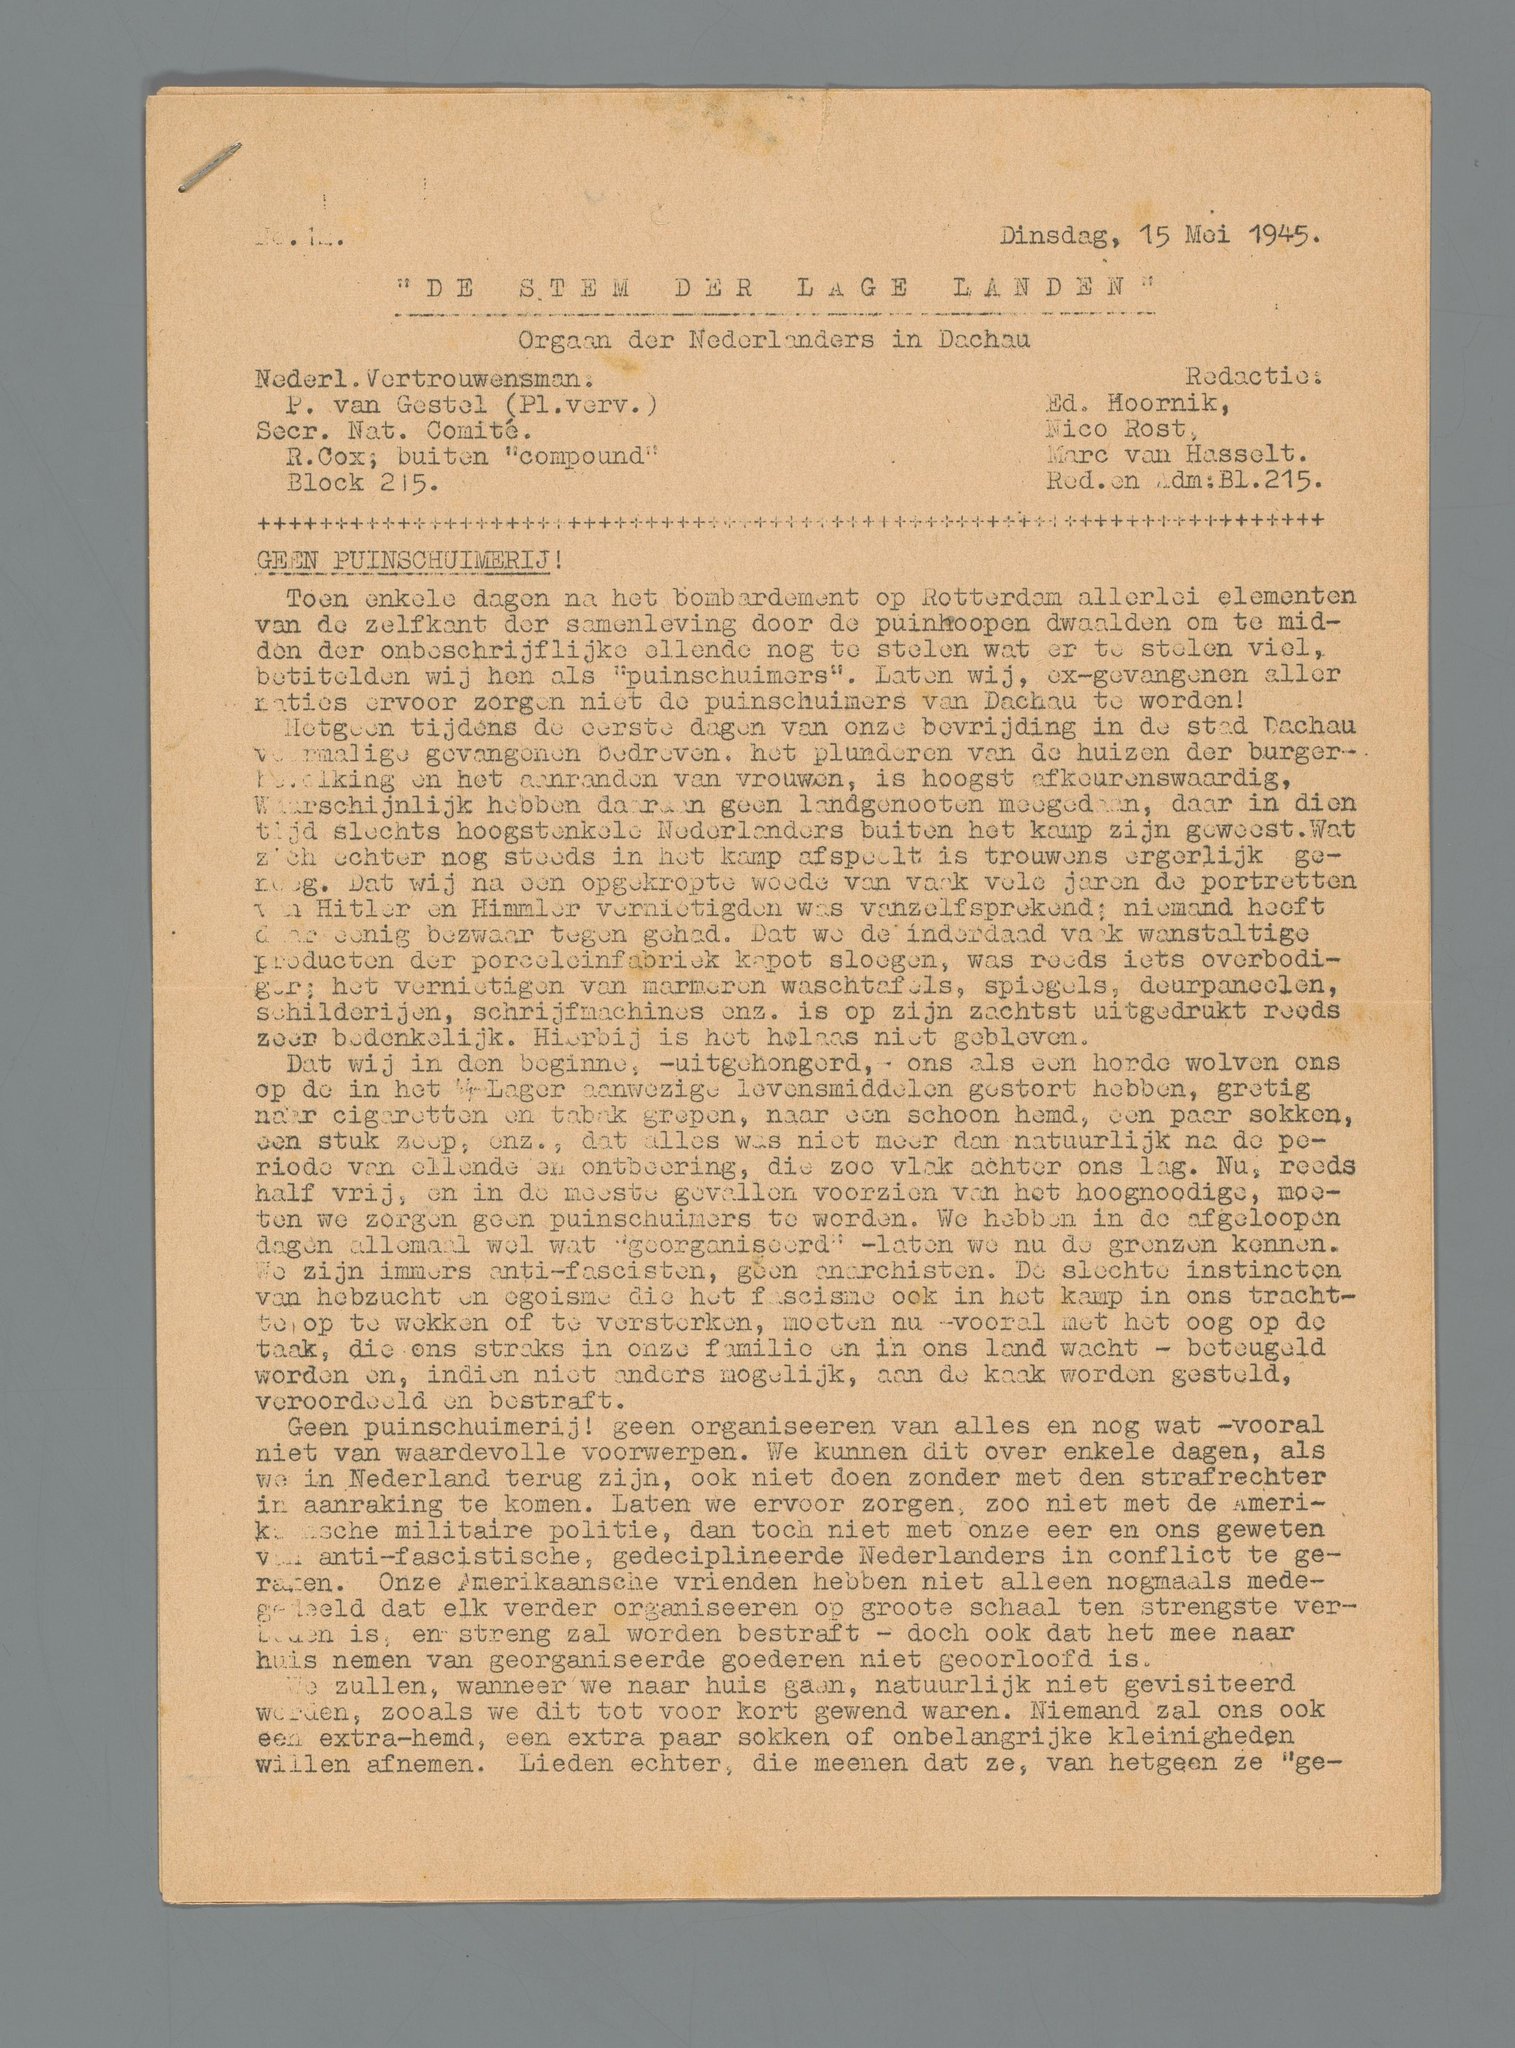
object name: pamphlet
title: De stem der lage landen, nr. 12, 15 mei 1945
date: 1945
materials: paper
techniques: mimeography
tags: rotterdam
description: Gestencilde krant 'De stem der lage landen / Orgaan der Nederlanders in Dachau', aflevering nr. 12, 15 mei 1945. Drie bladen bedrukt op vijf zijden. Verschenen onder redactie van Ed Hoornik, Nico Rost en Marc van Hasselt.